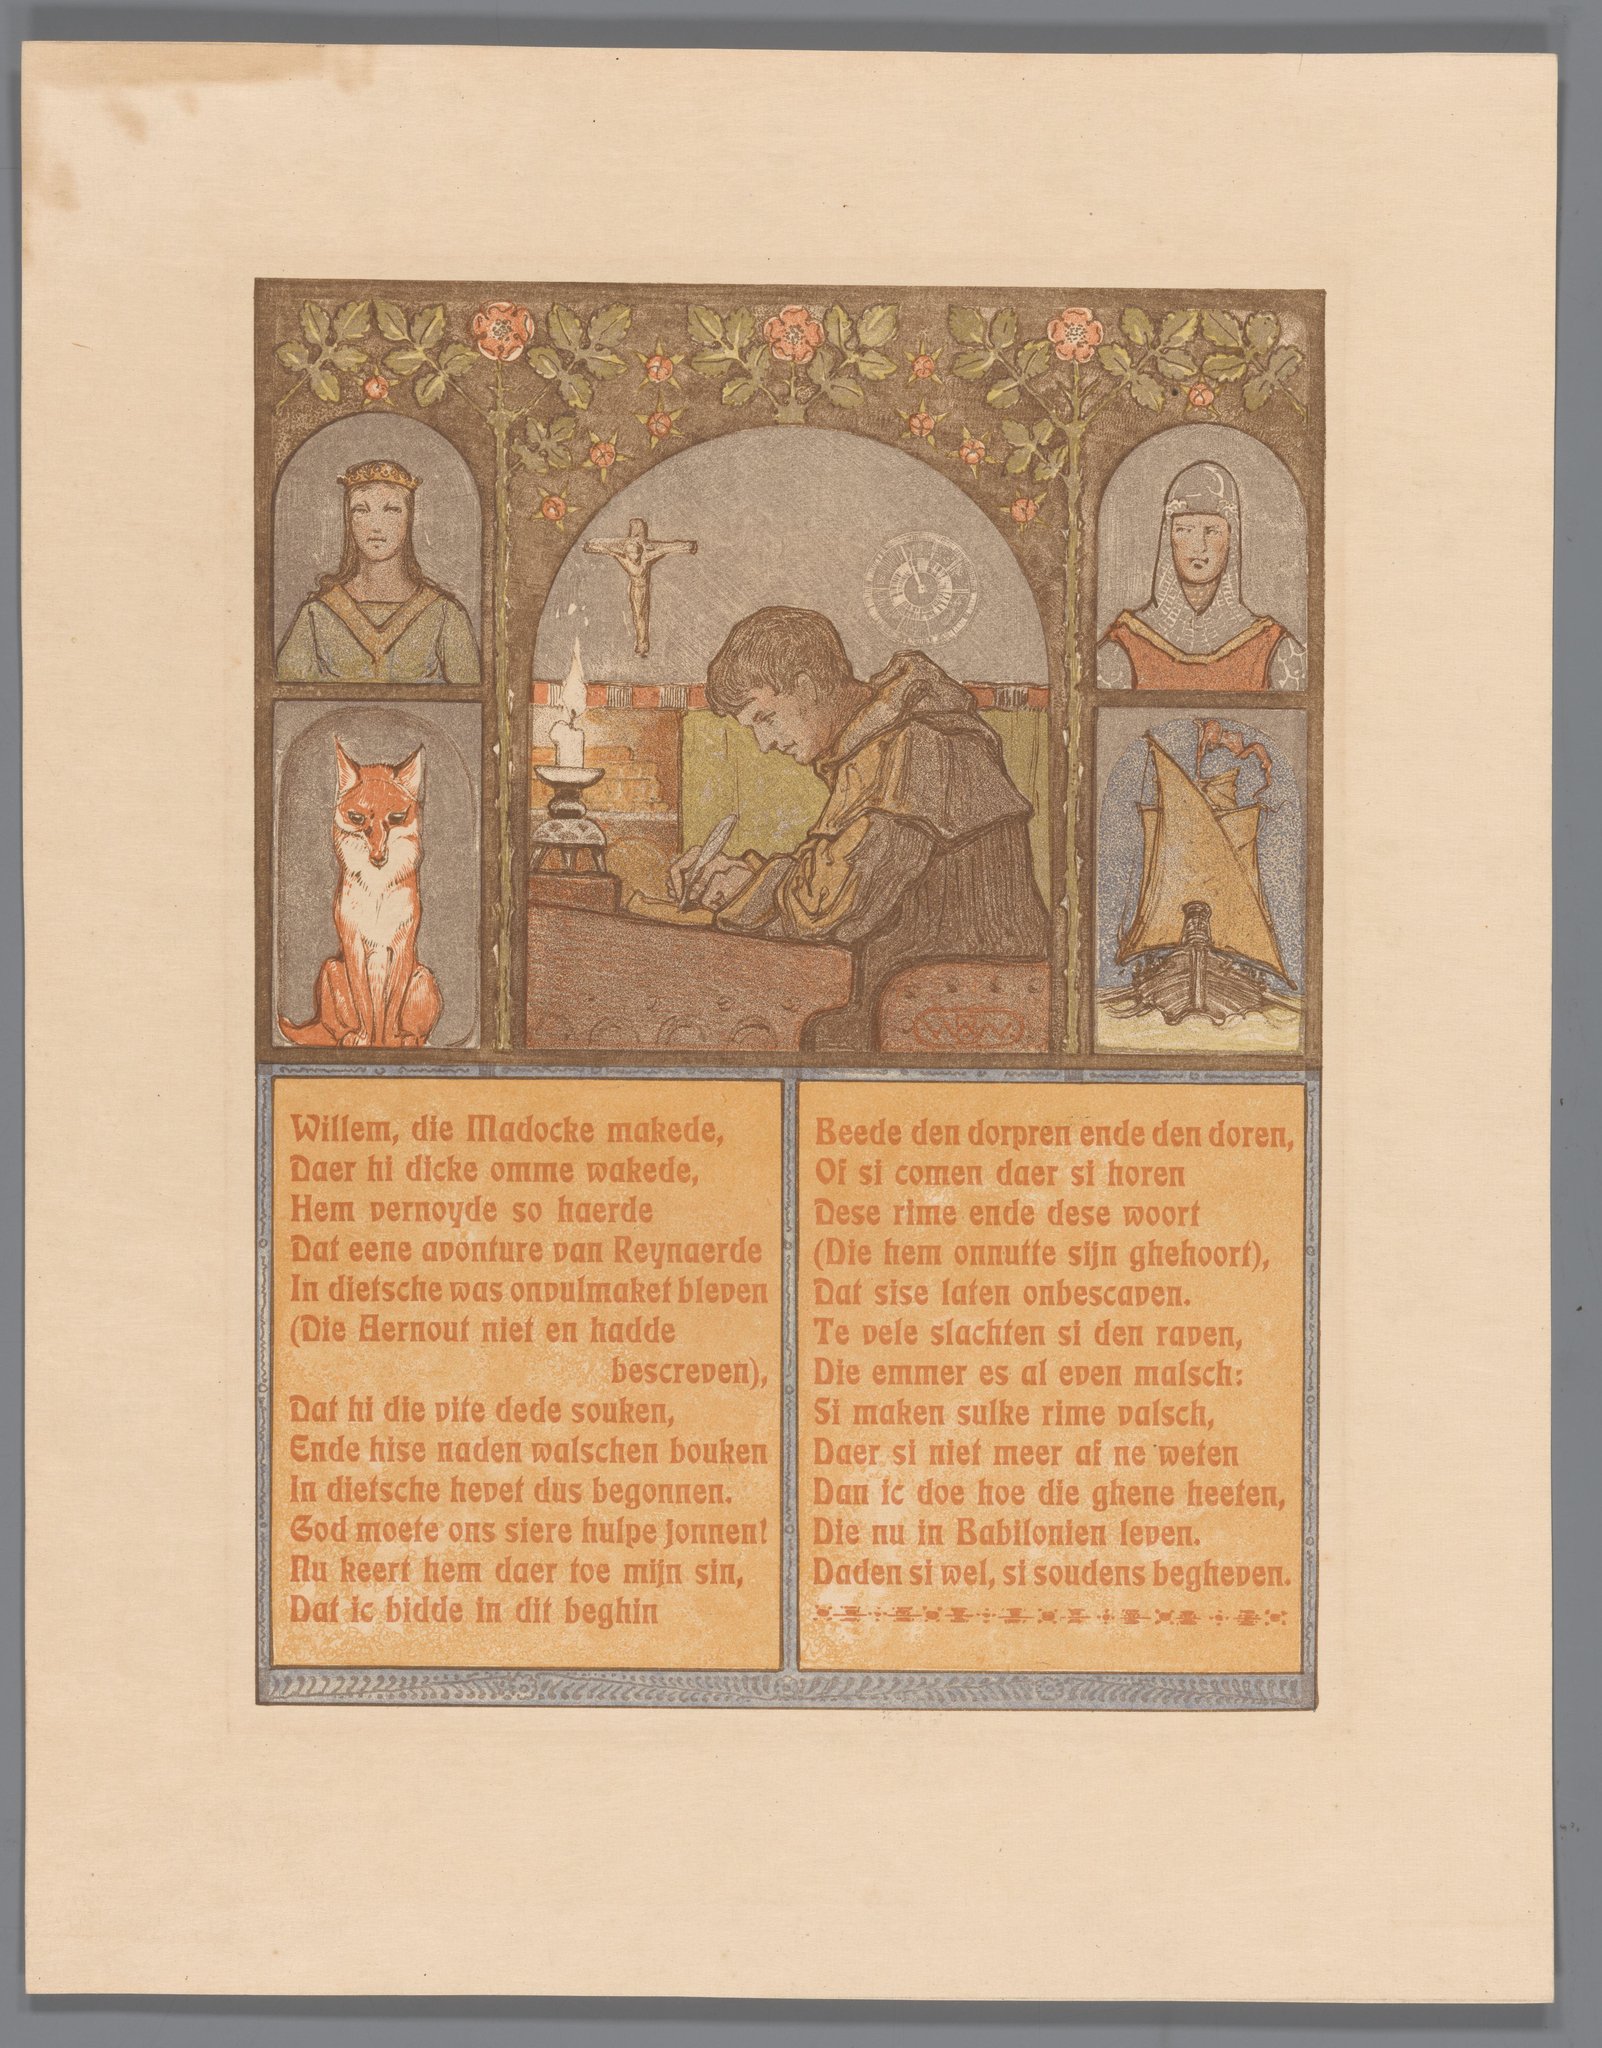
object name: book illustration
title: Schrijvende monnik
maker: bernard willem wierink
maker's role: draughtsman, print maker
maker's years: 1856-1939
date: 1910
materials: paper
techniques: lithograph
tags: fable of reynard the fox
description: Prent gebruikt in: Streuvels, Stijn (Frank Lateur). Reinaert de Vos naar verschillende uitgaven van het middeleeuwsche epos. Amsterdam: L.J. Veen, 1910.